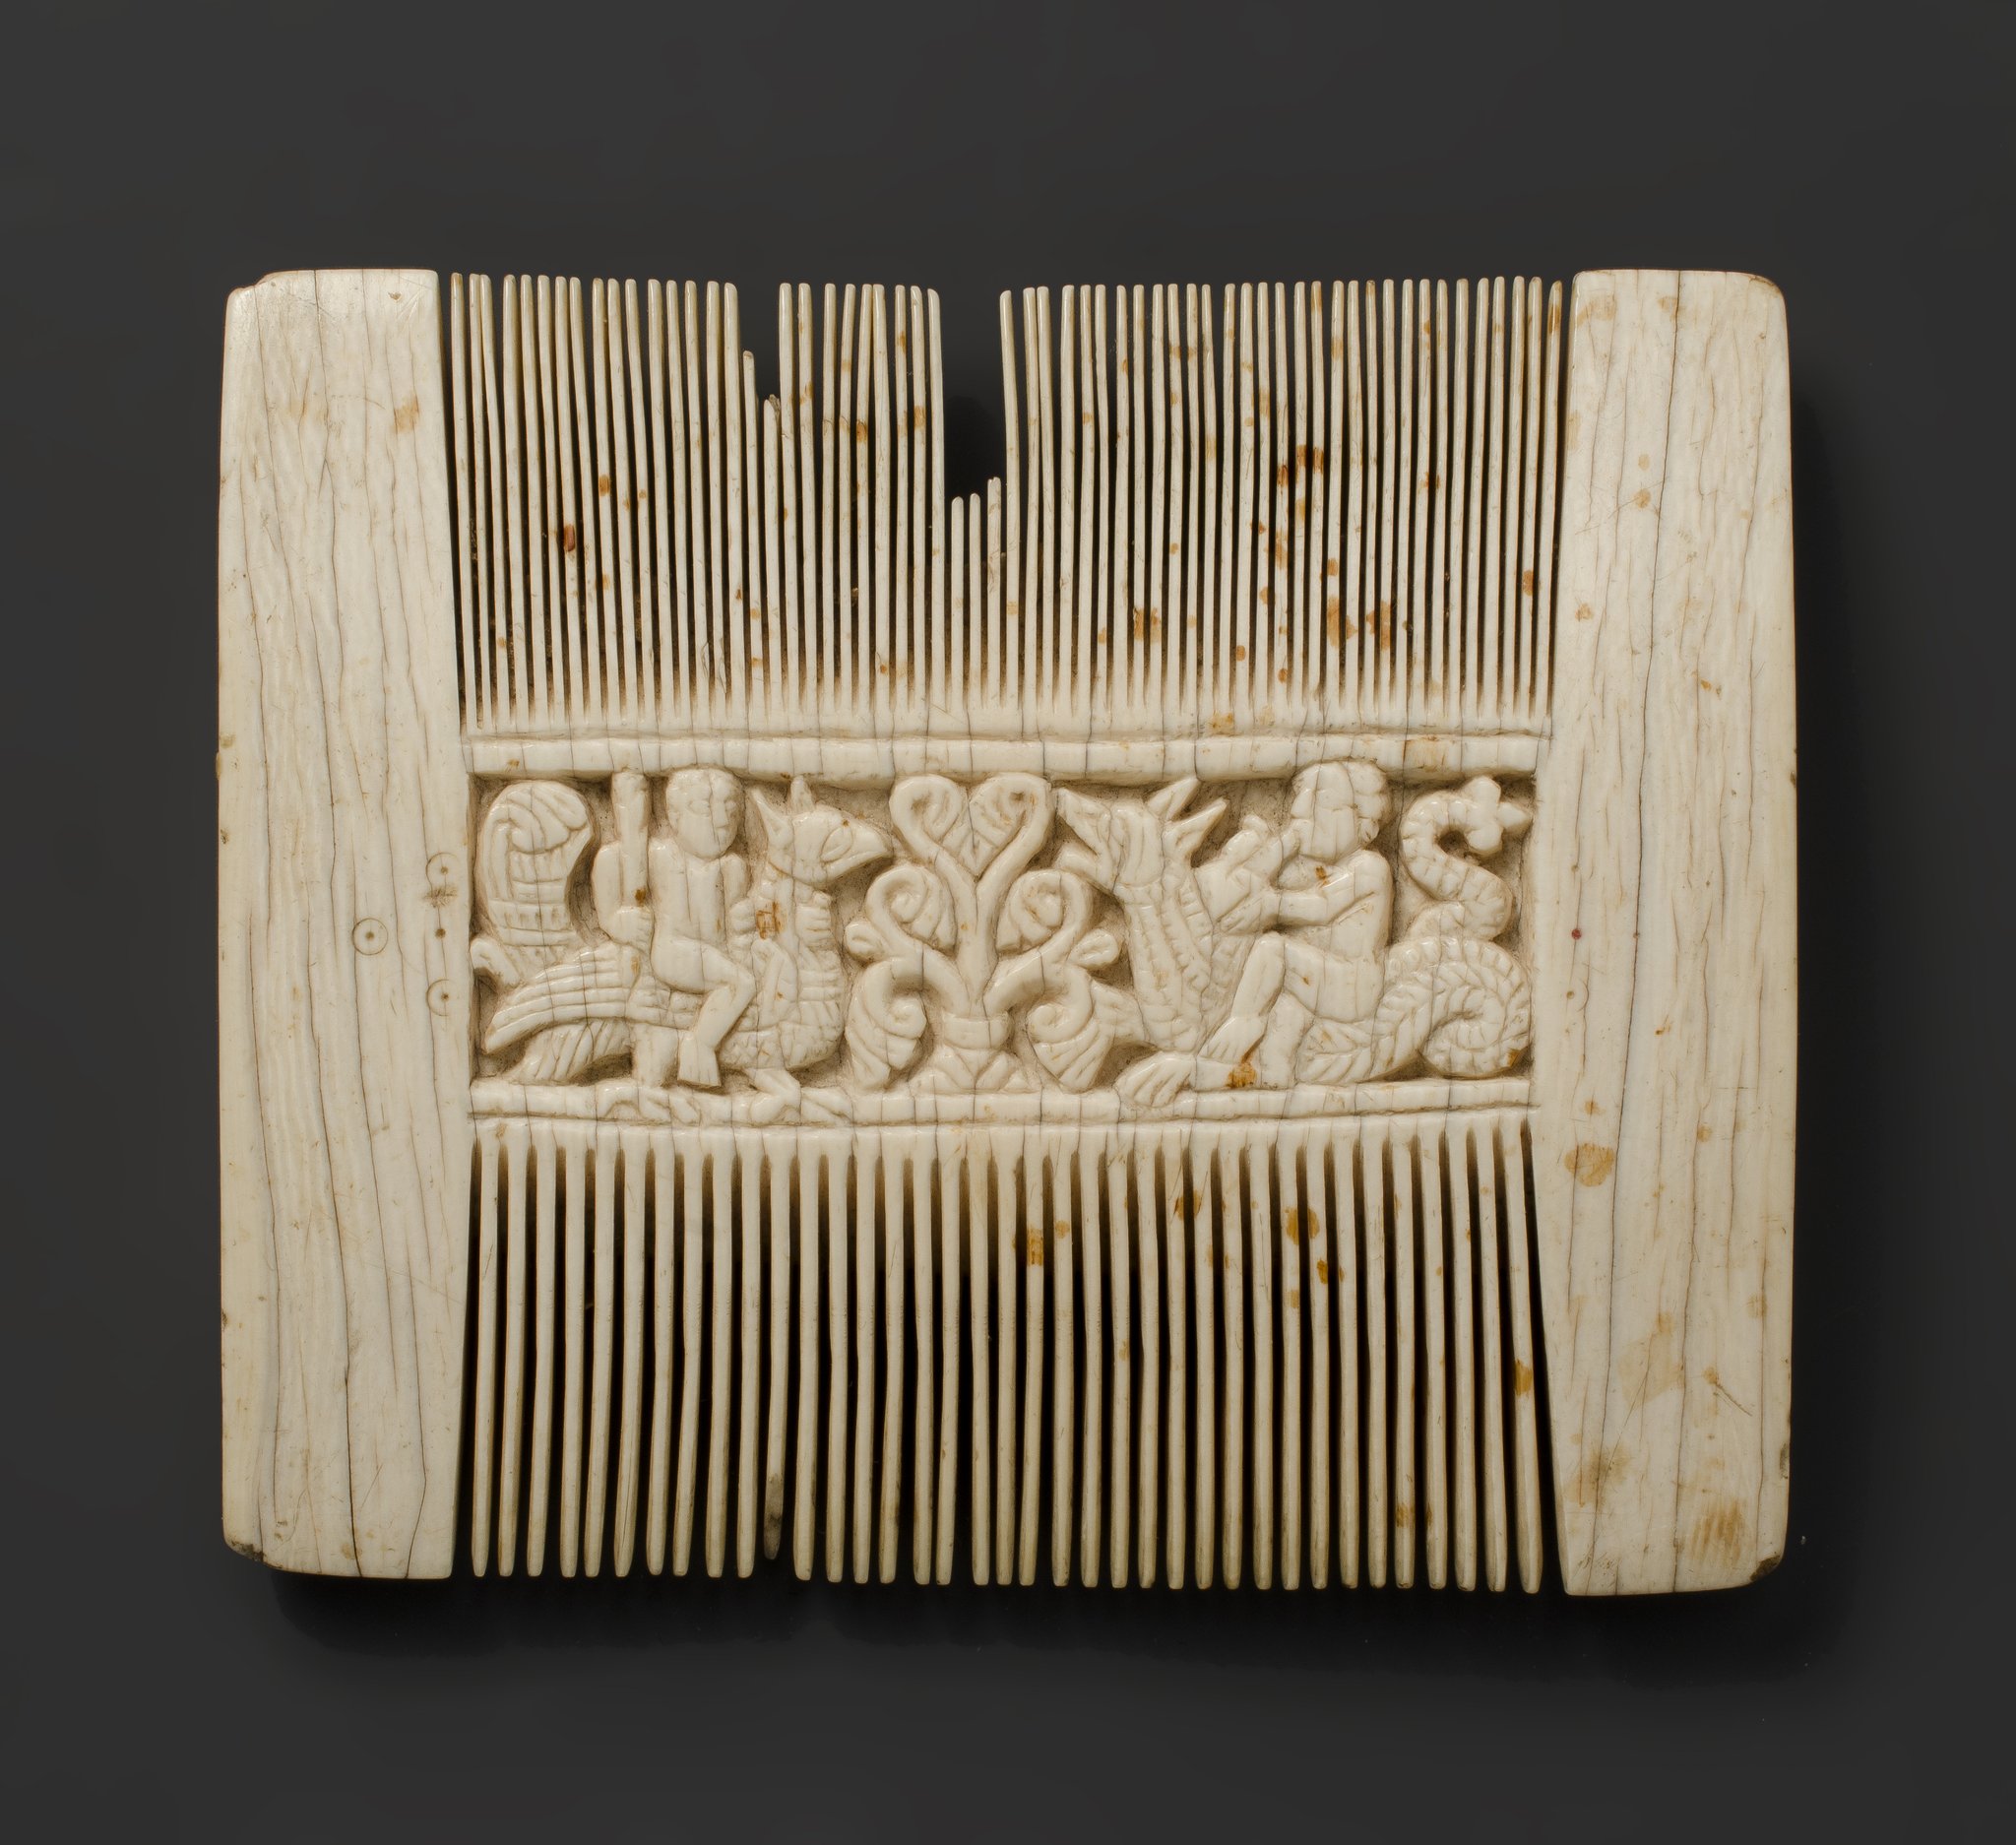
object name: comb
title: Comb with Putti and Sea Creatures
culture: italian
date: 1067-1133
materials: ivory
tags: griffins